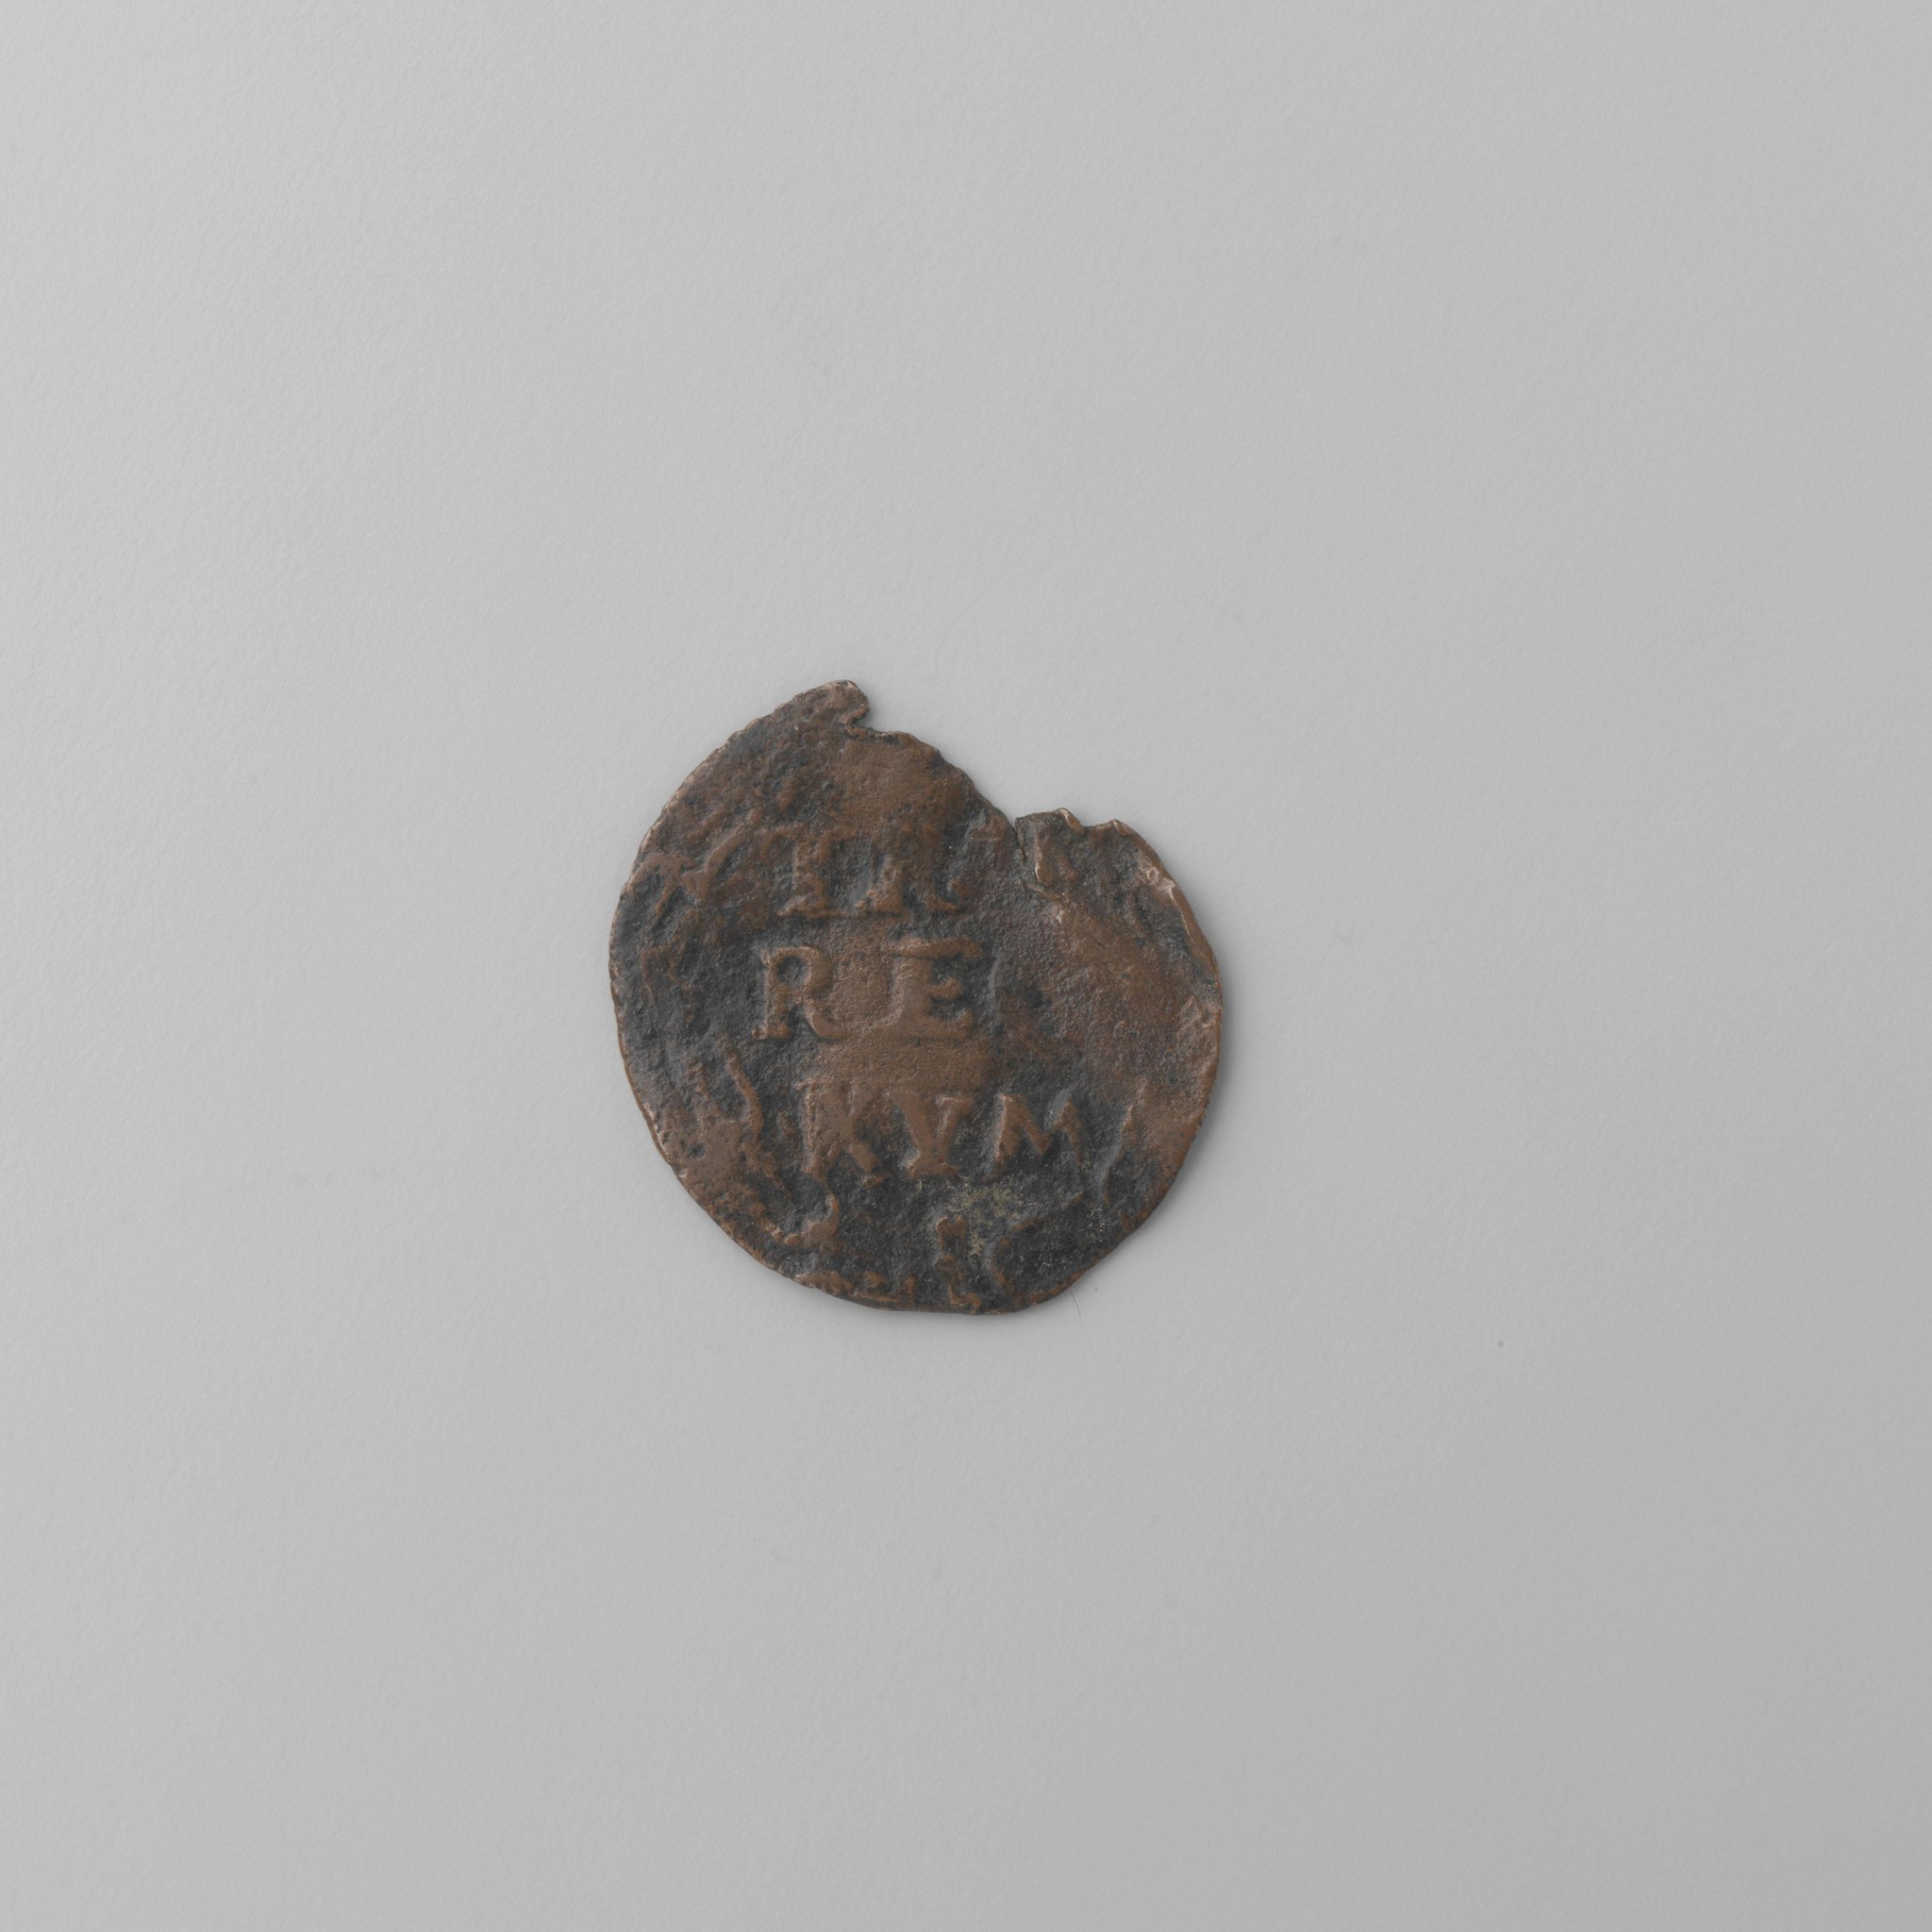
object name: coin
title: Reckheimse duit van Ferdinand van Aspremont-Lynden (1636-1665)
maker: heer van reckheim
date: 1636-1665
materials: copper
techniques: striking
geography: rekem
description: Koperen munt. Voorzijde: versierd wapenschild. Keerzijde: binnen een krans drie-regelig opschrift. Muntplaatje uitgebroken.